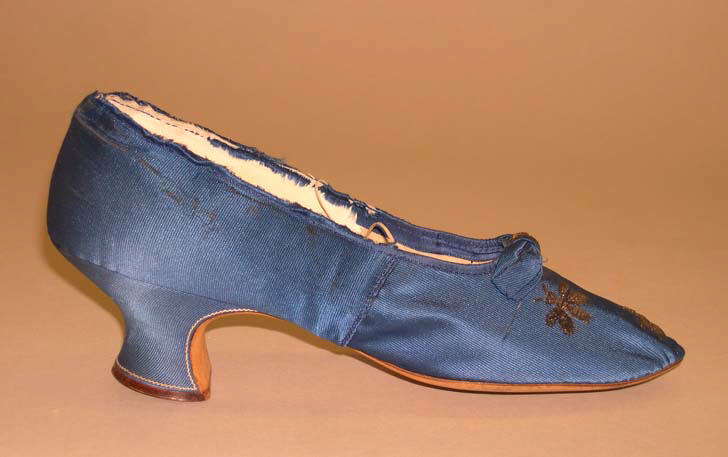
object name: slipper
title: Slippers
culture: french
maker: meier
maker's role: designer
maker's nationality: french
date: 1900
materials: silk